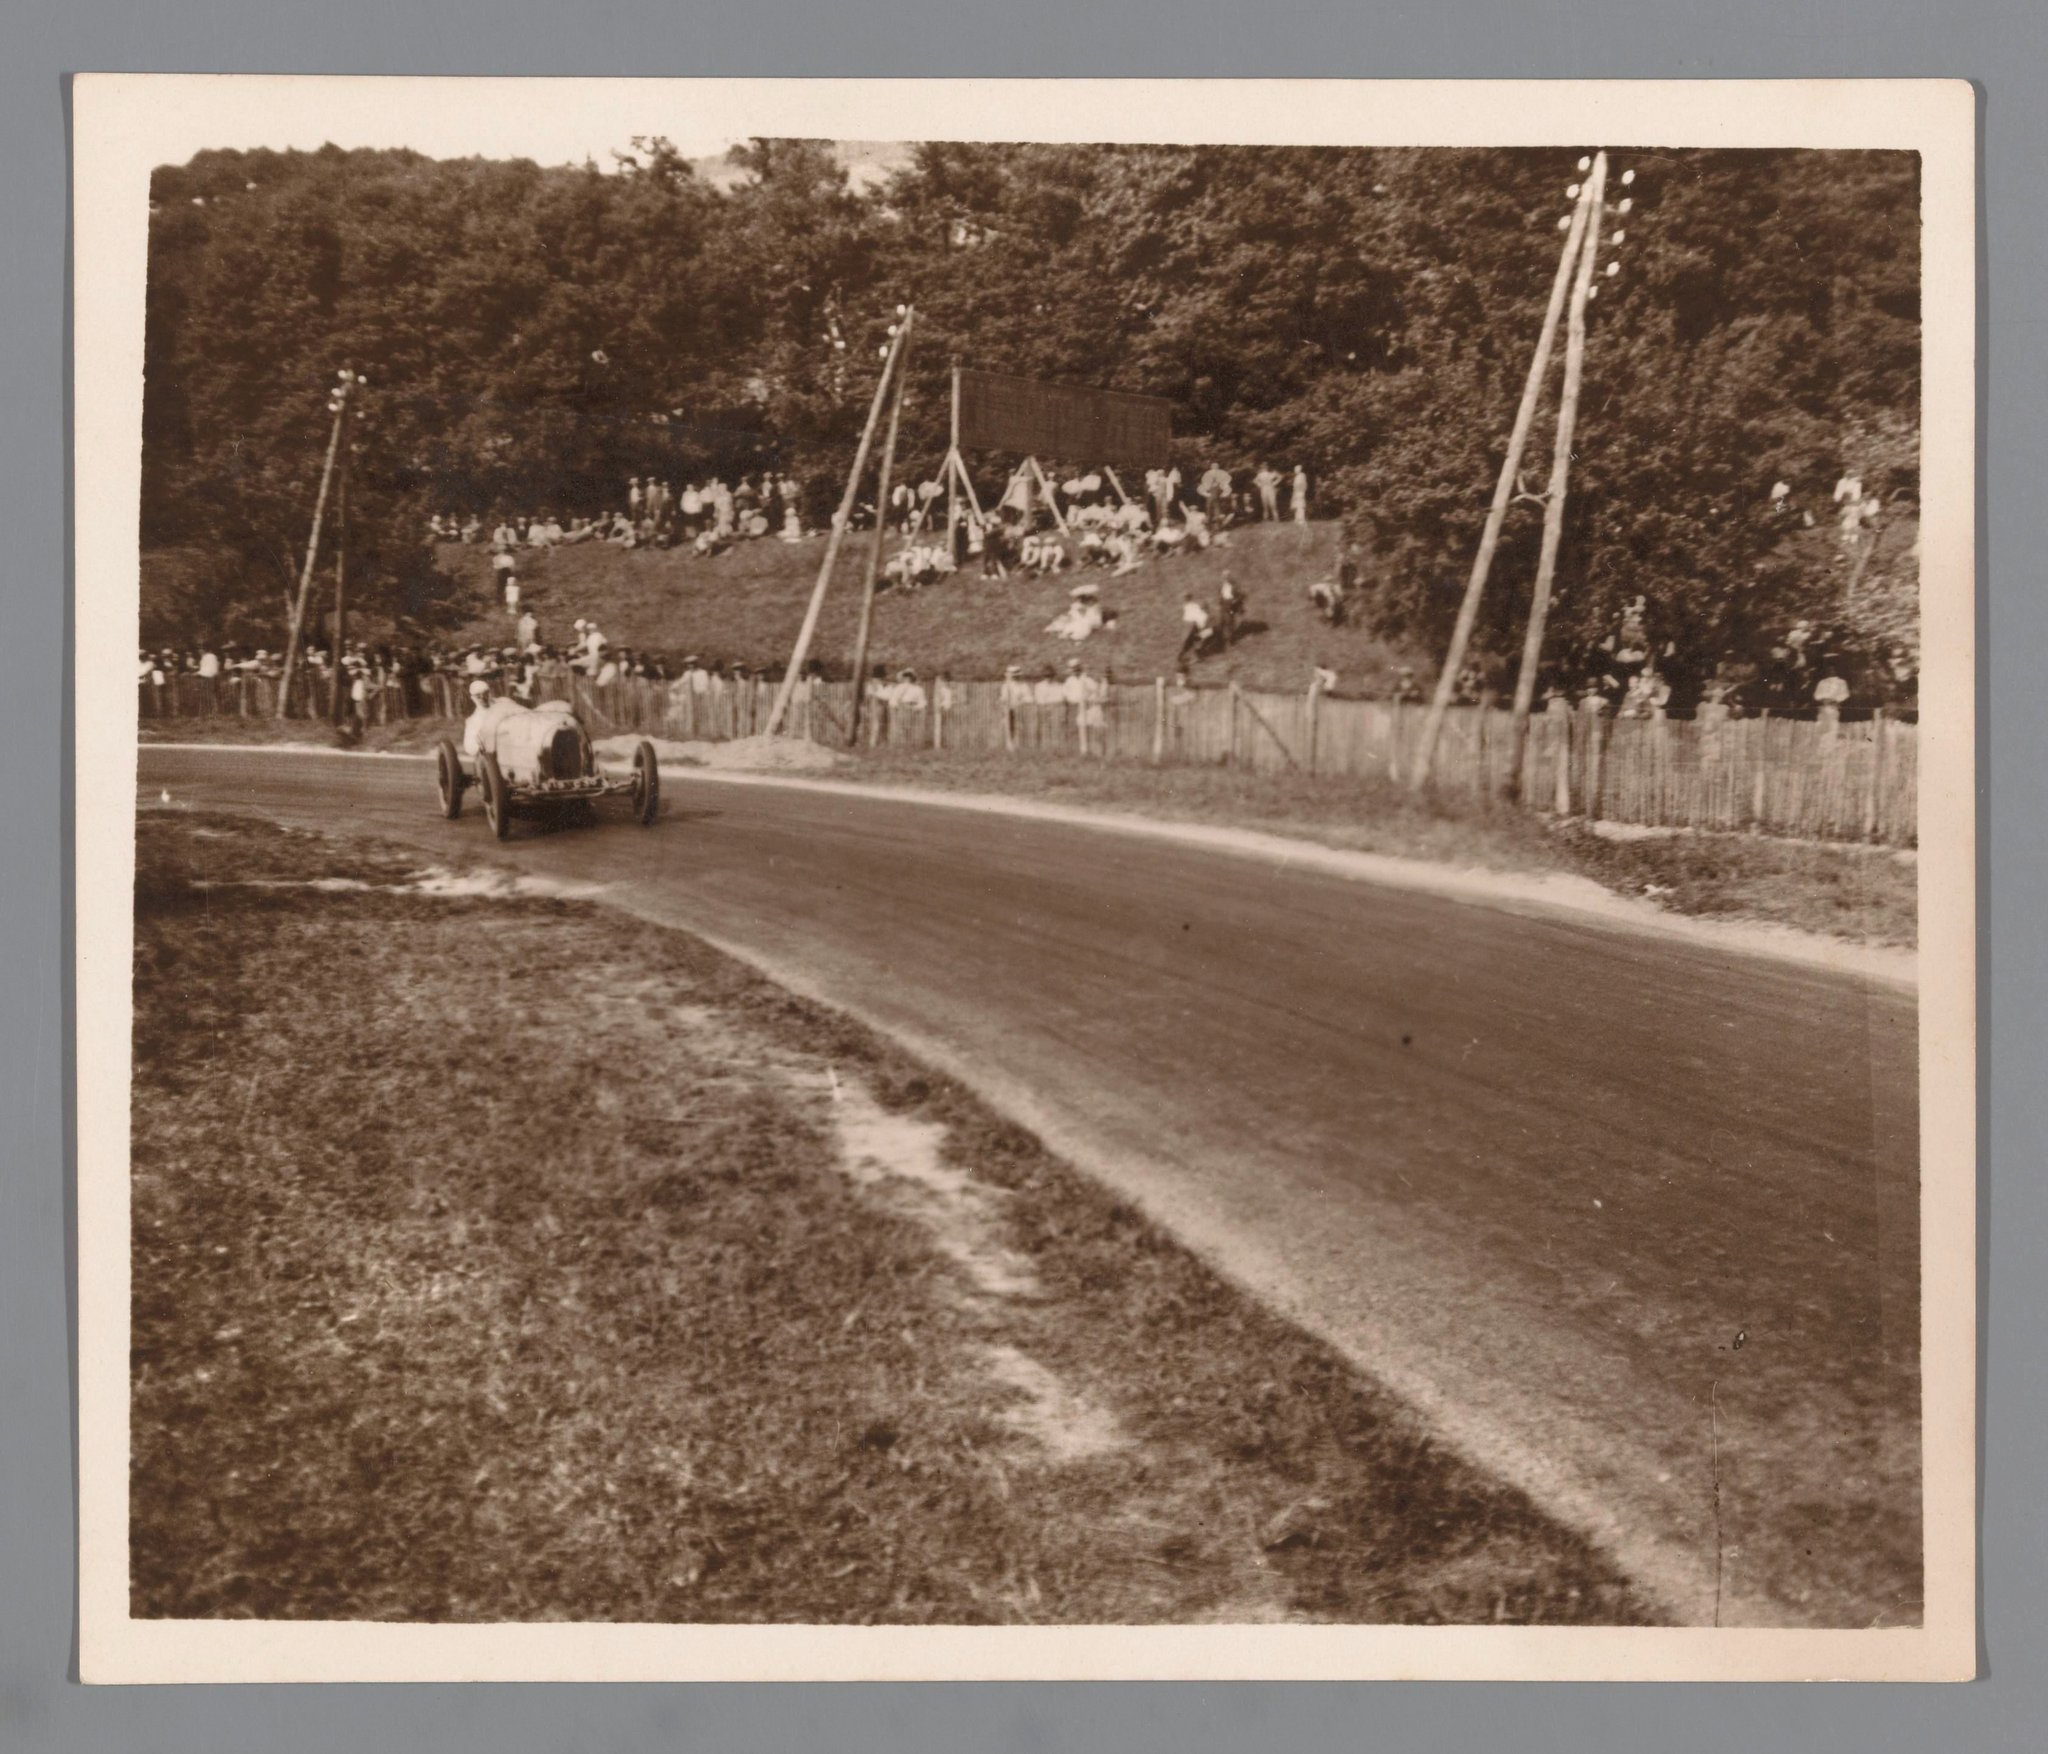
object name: photograph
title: Raceauto op een racebaan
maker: Anonymous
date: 1910-1925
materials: photographic support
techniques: gelatin silver print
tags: running, race, automobile